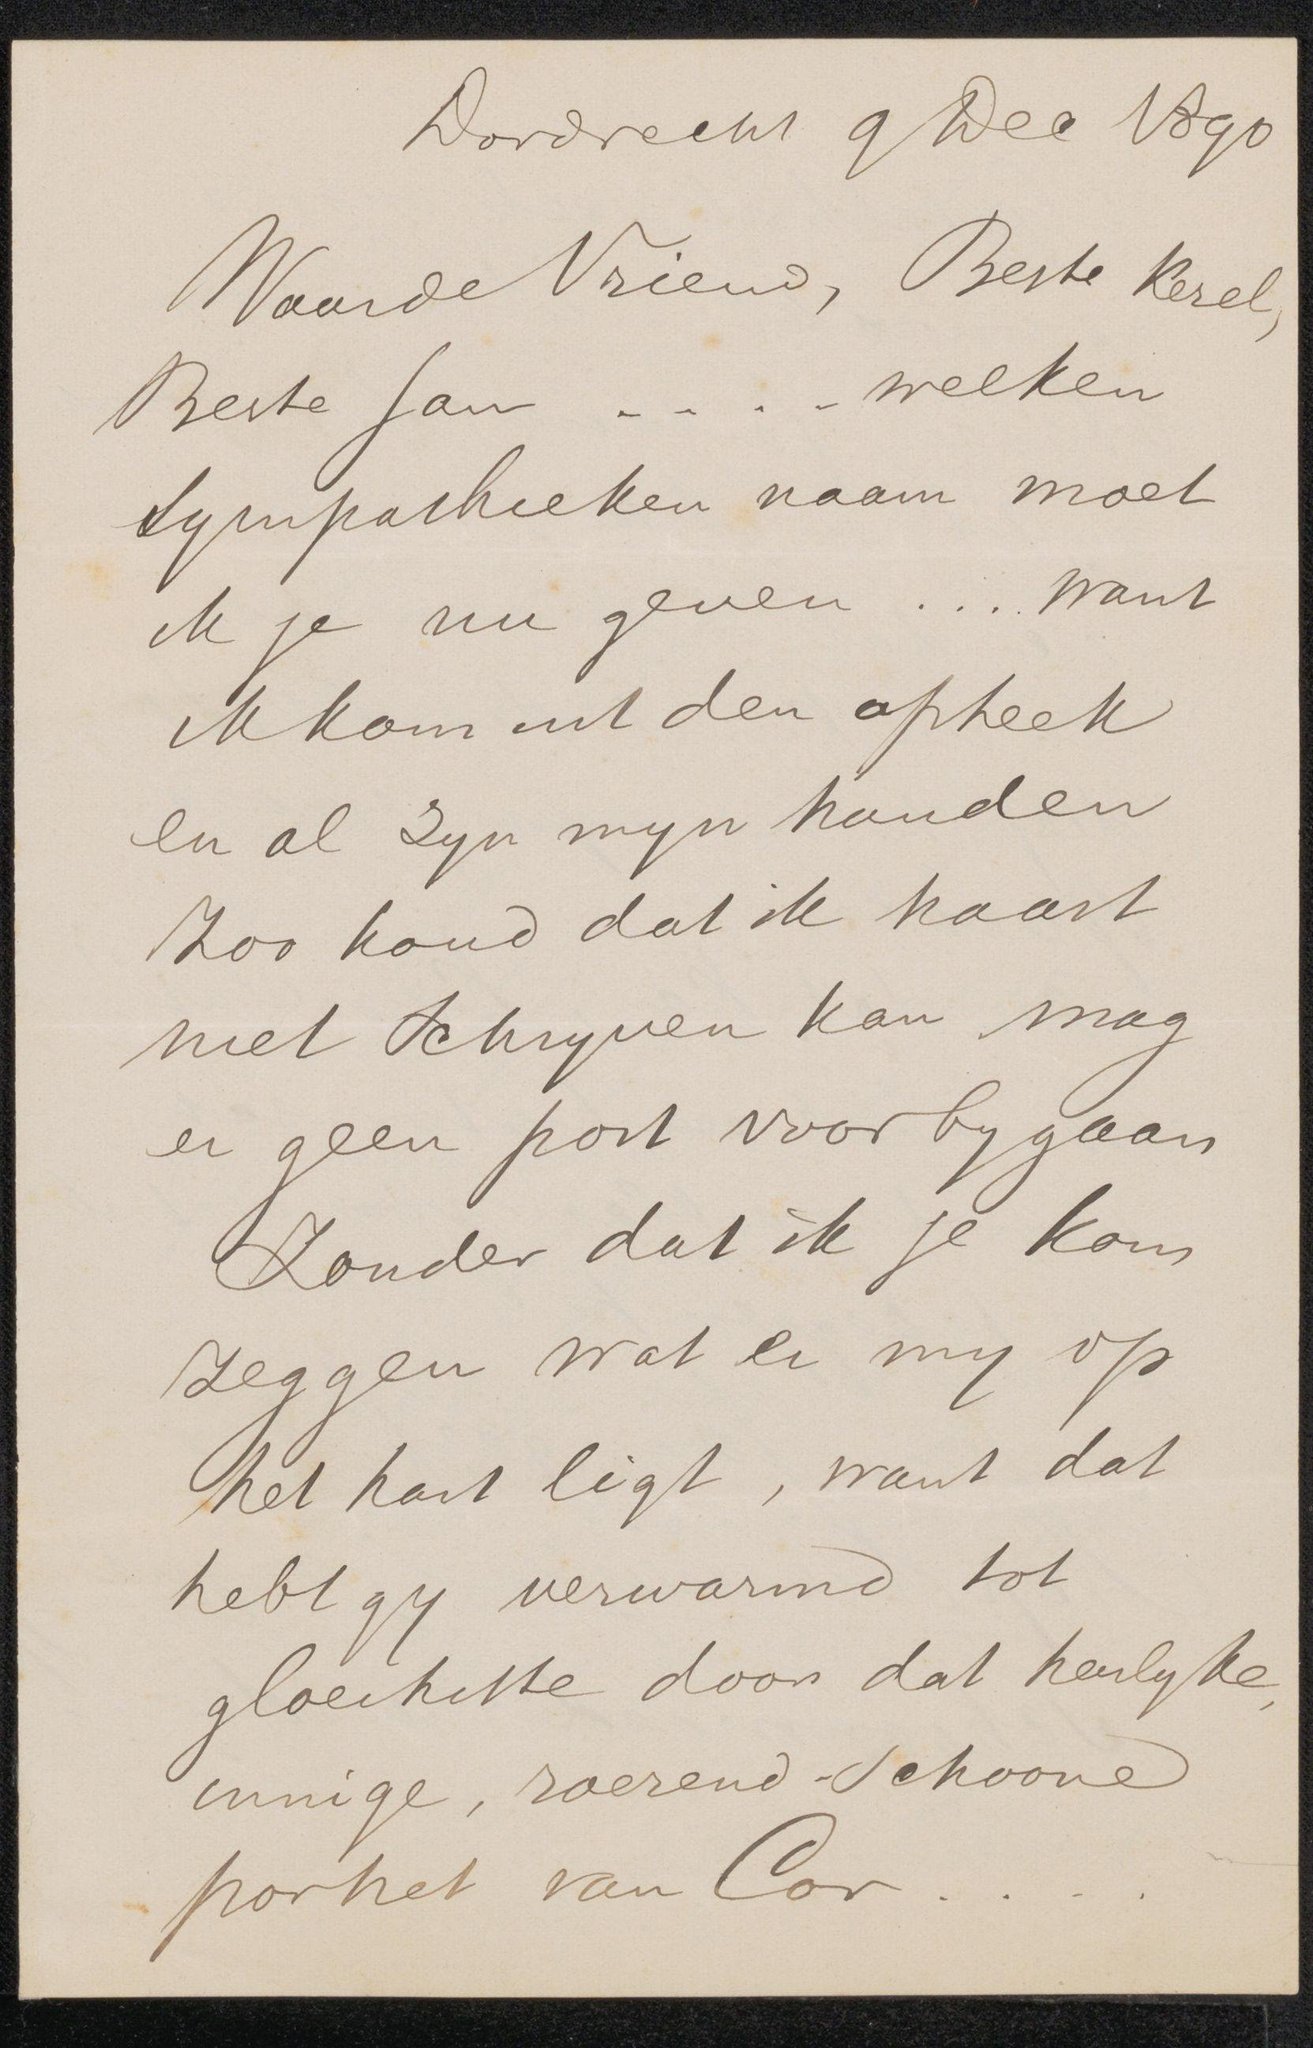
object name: letter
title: Brief aan Jan Veth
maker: martinus cornelis lebret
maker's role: verzamelaar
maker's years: 1833-1894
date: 1890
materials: ink, paper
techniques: pen, writing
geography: dordrecht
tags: amsterdam, painter, print maker, draughtsman, designer, jan veth, historical persons (portraits and scenes from the life), printed matter, berlin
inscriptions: collector's mark: ‘RPK’